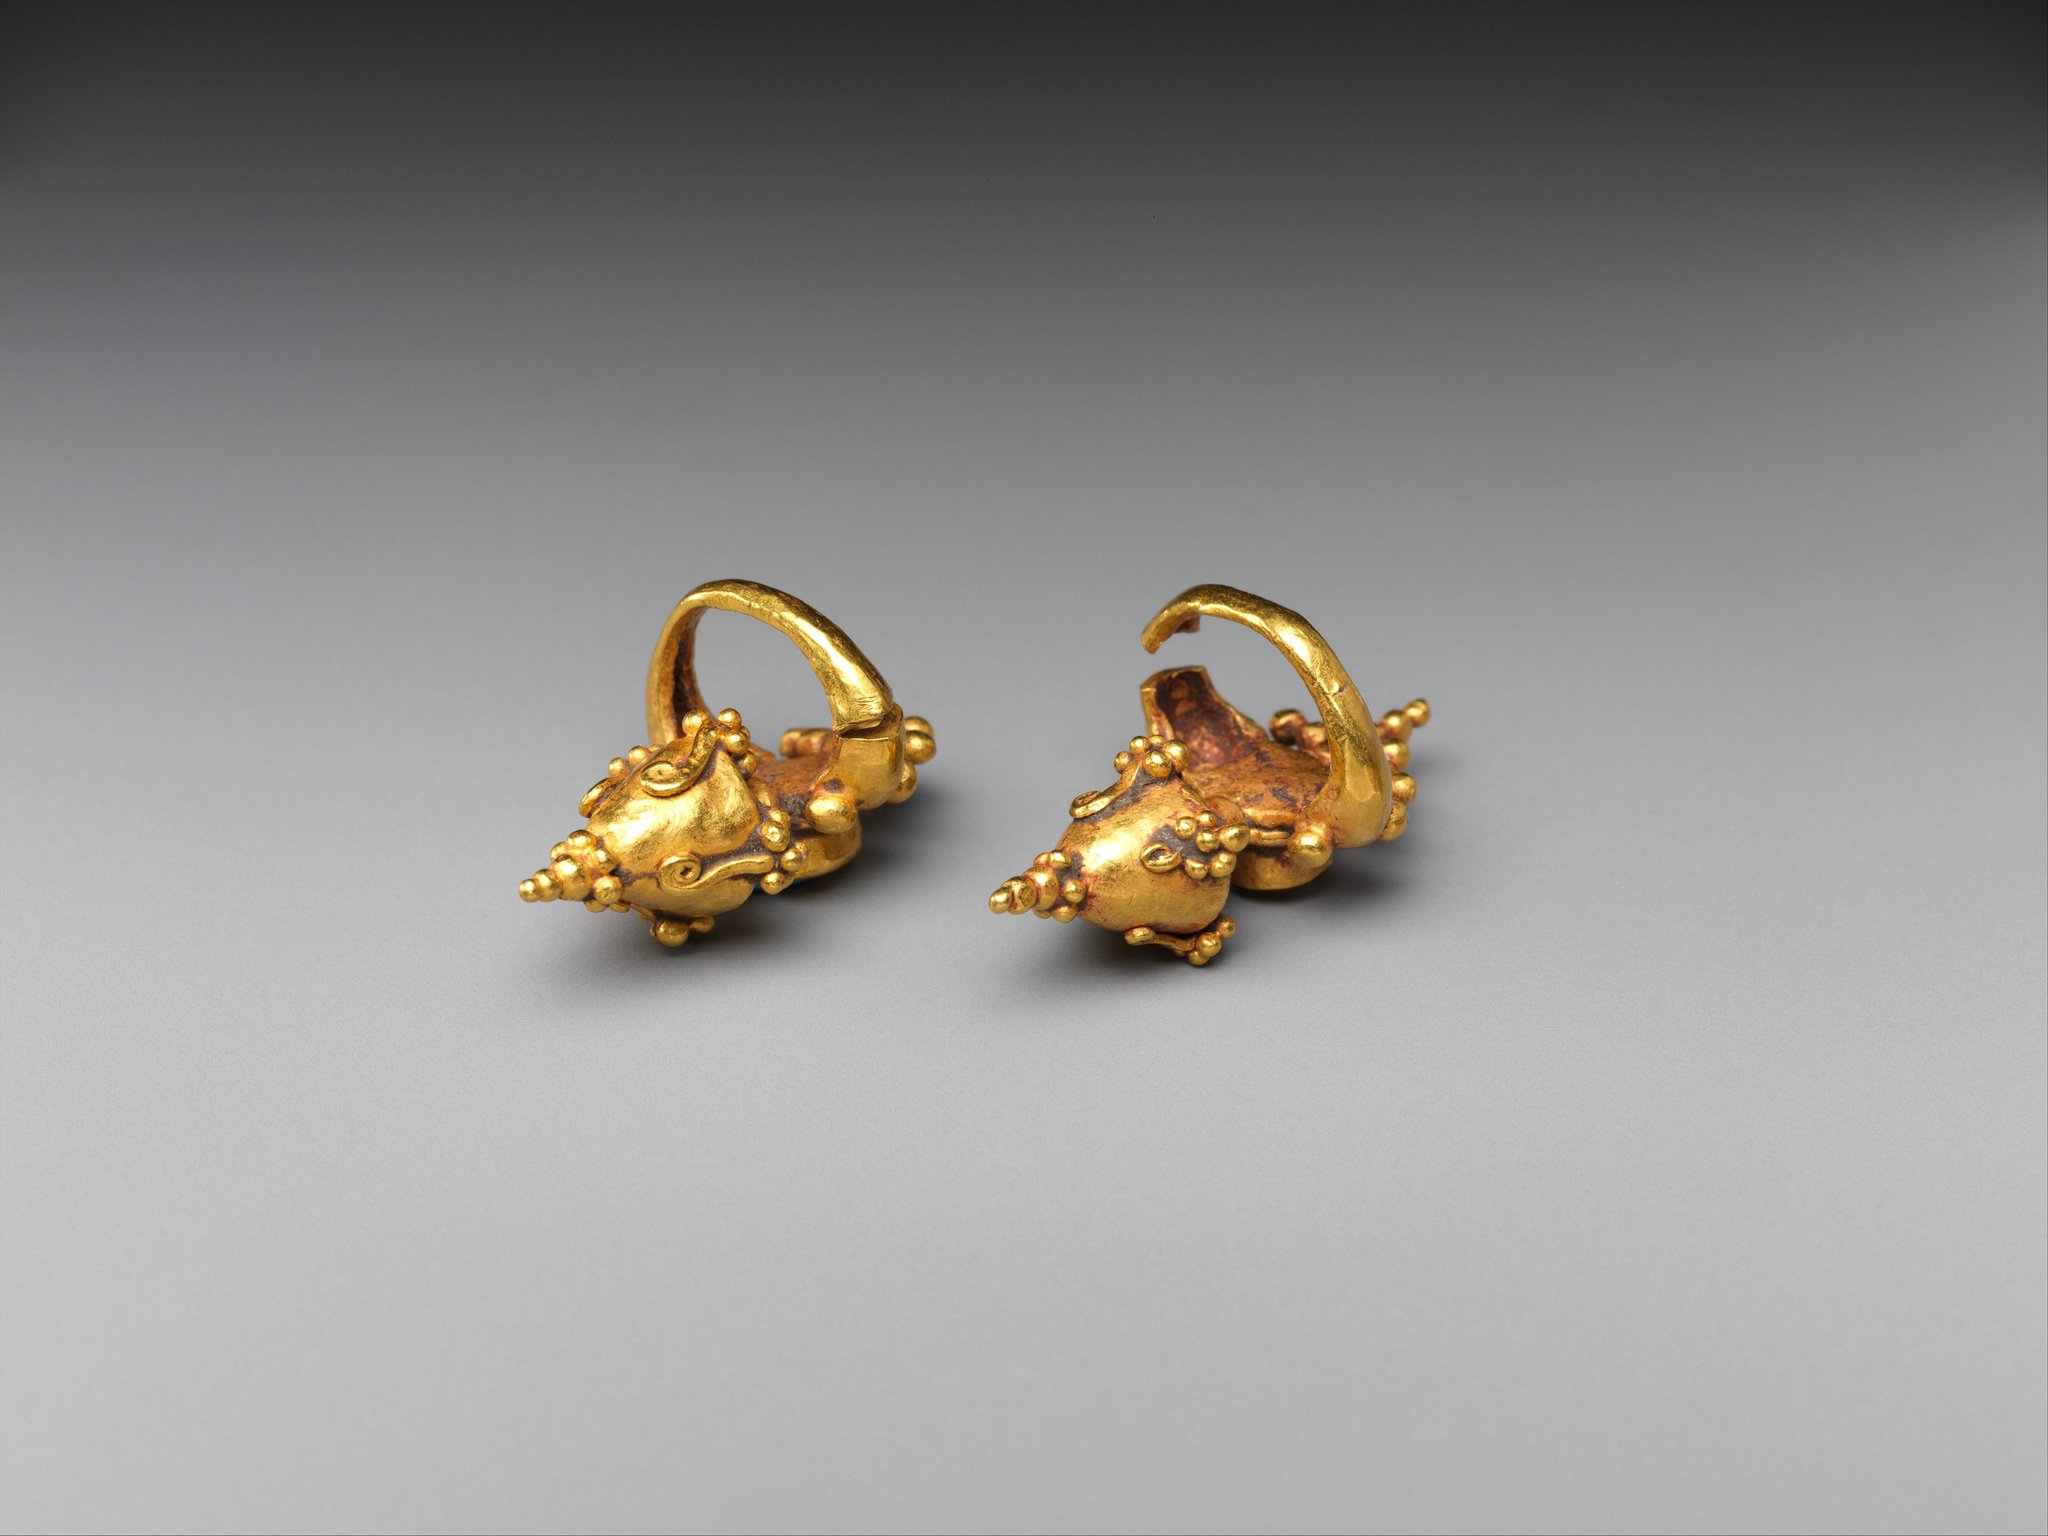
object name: ear clip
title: Pair of Ear Clips with Granulate Design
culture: indonesian, javanese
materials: gold